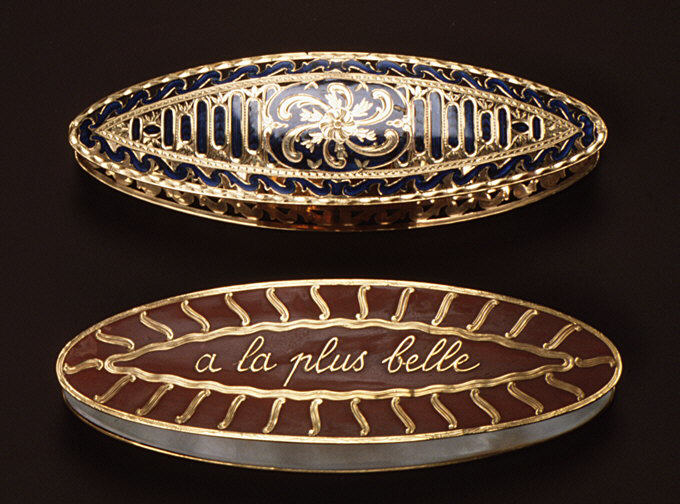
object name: shuttle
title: Shuttle (navette)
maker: mathieu coiny fils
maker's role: maker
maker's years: 1723-1823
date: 1763-1764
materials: enamel, gold